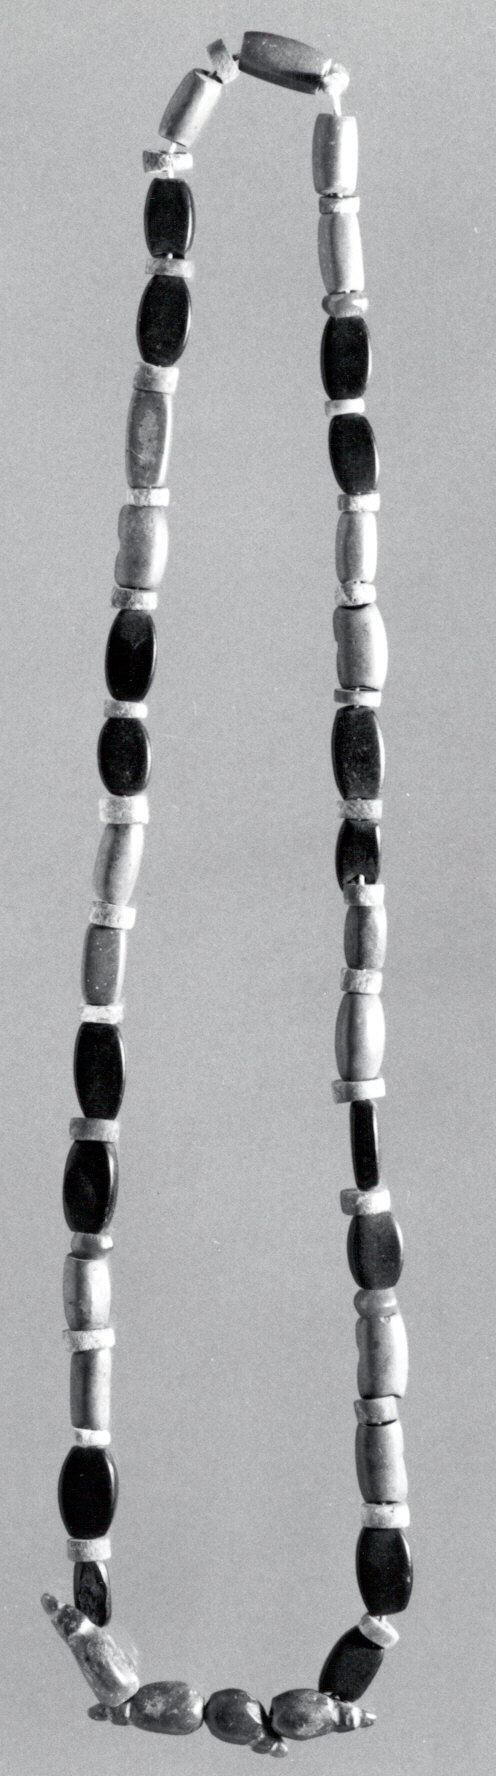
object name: necklace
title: Necklace of Stone Beads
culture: moche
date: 201-600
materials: stone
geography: peru